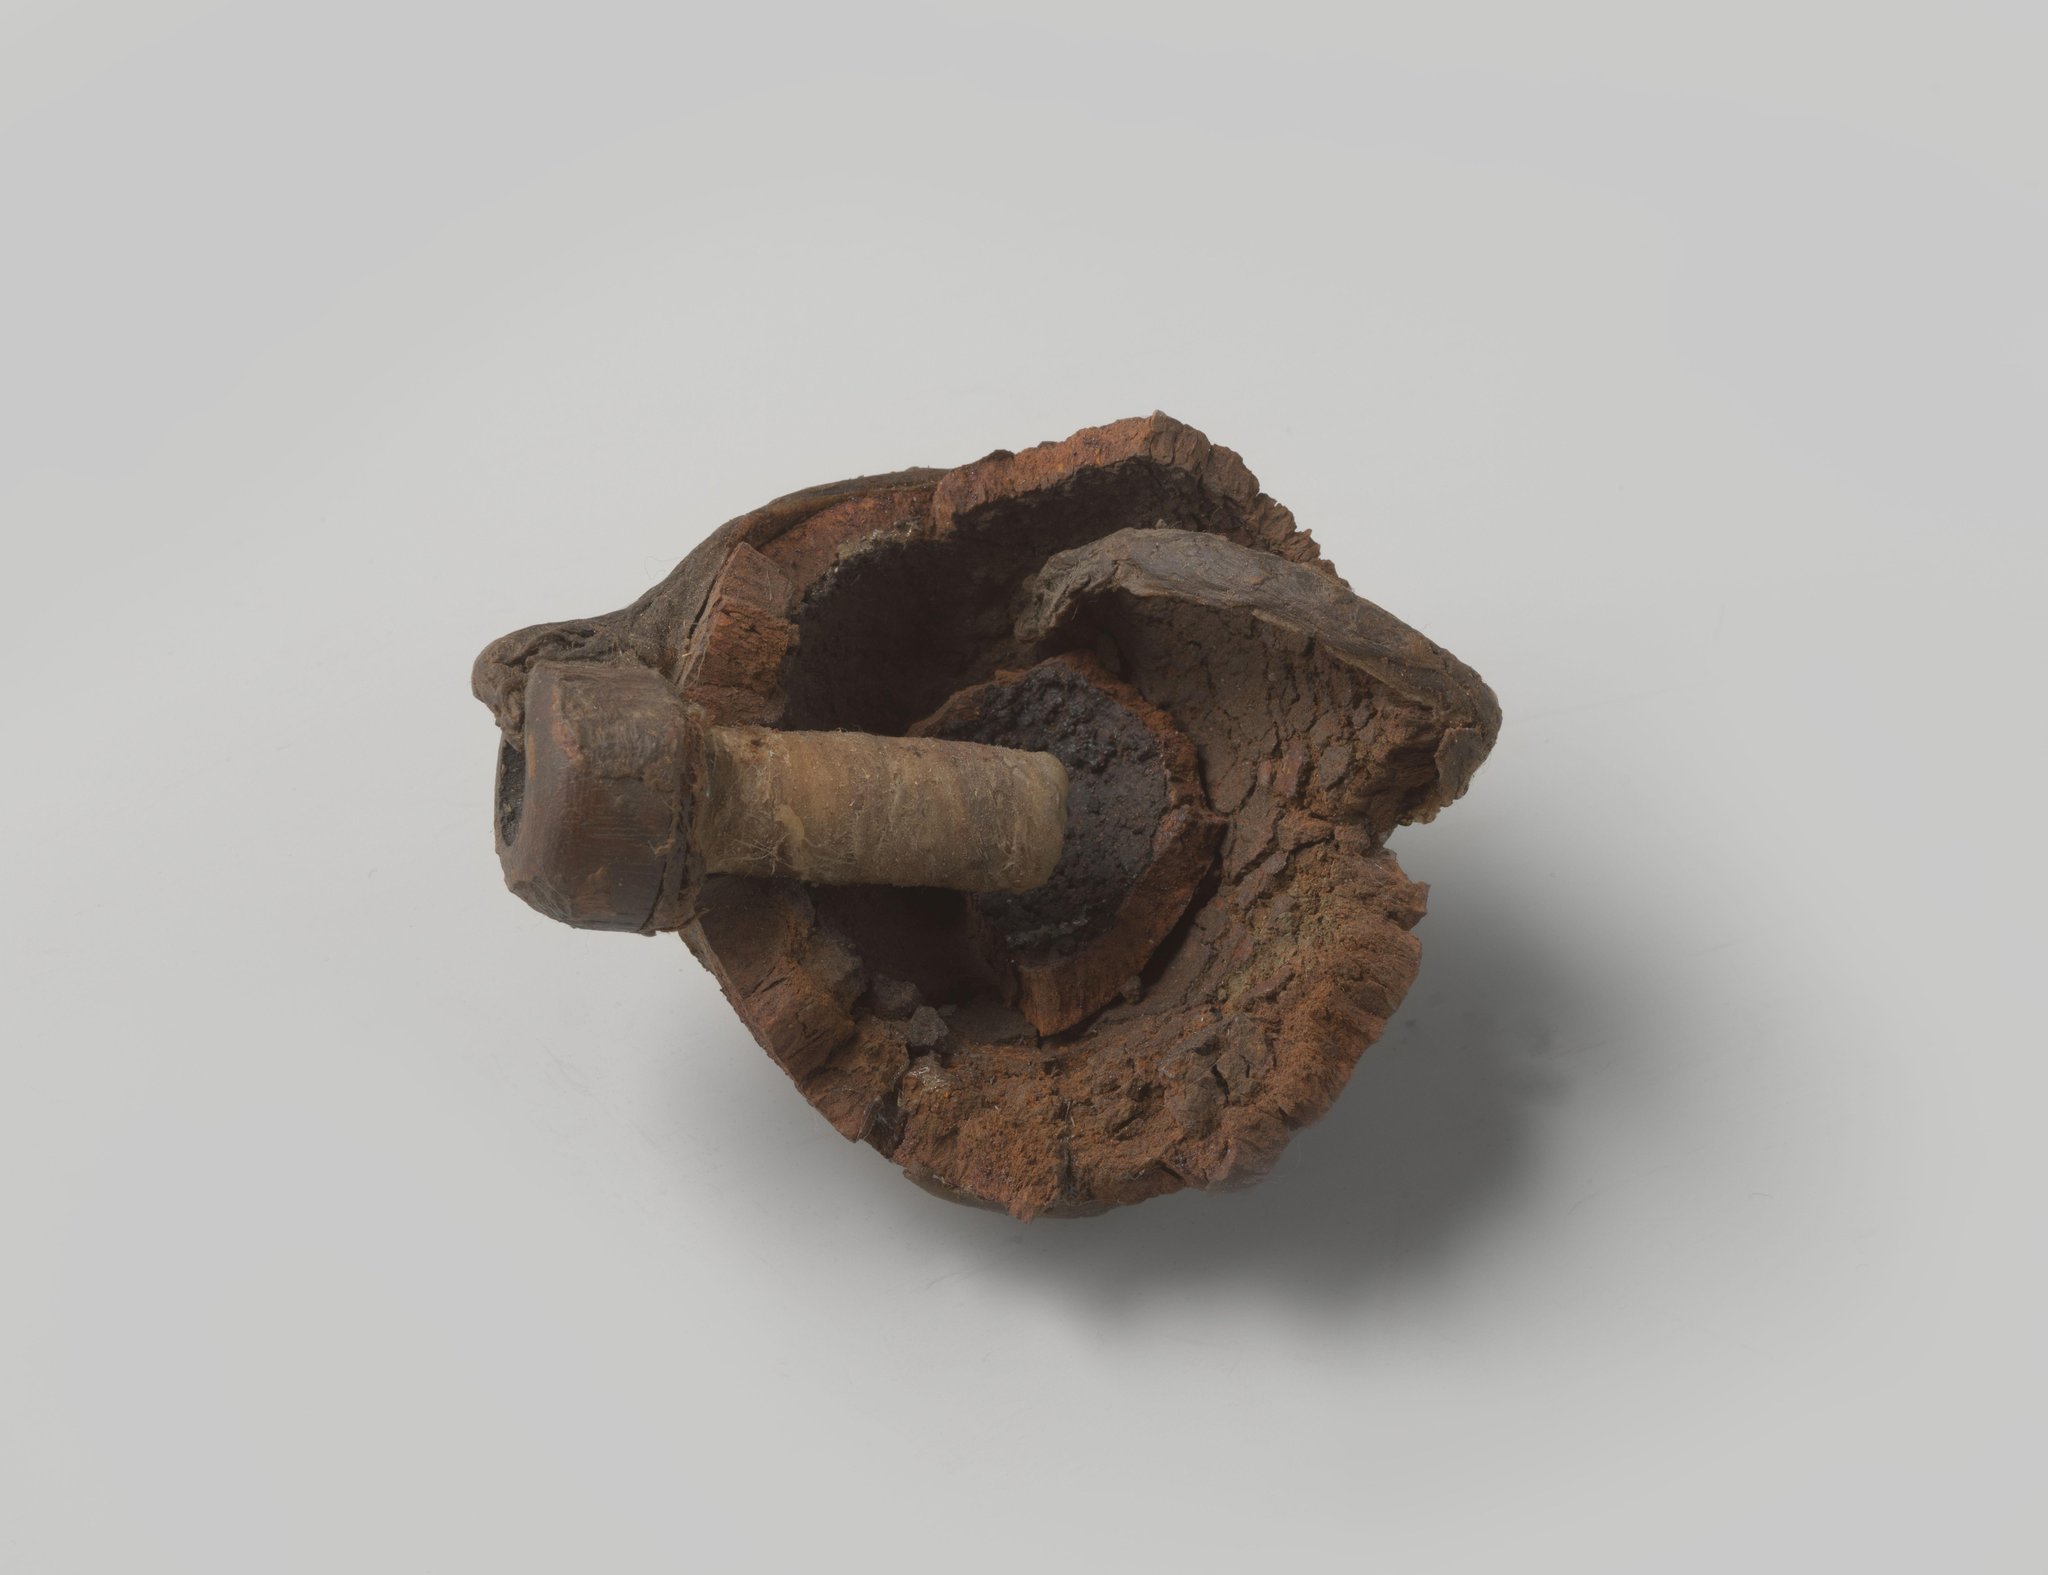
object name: hand grenade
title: Gefragmenteerde handgranaat uit het wrak van de Oostindiëvaarder Hollandia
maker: Anonymous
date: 1700-1743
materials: iron